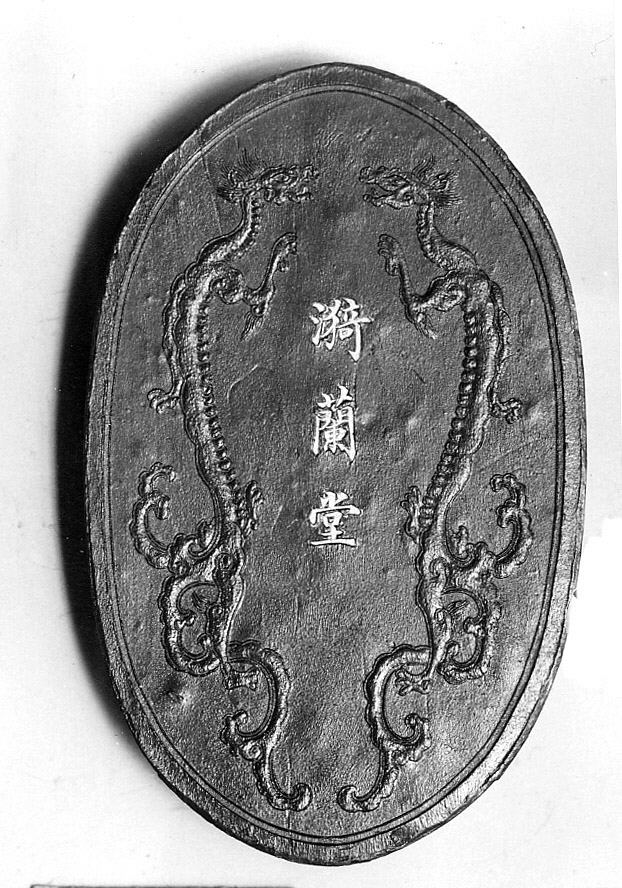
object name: ink tablet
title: Rippling Water Hall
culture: chinese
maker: jian guzhai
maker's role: artist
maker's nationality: chinese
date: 1867-1933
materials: ink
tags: dragons